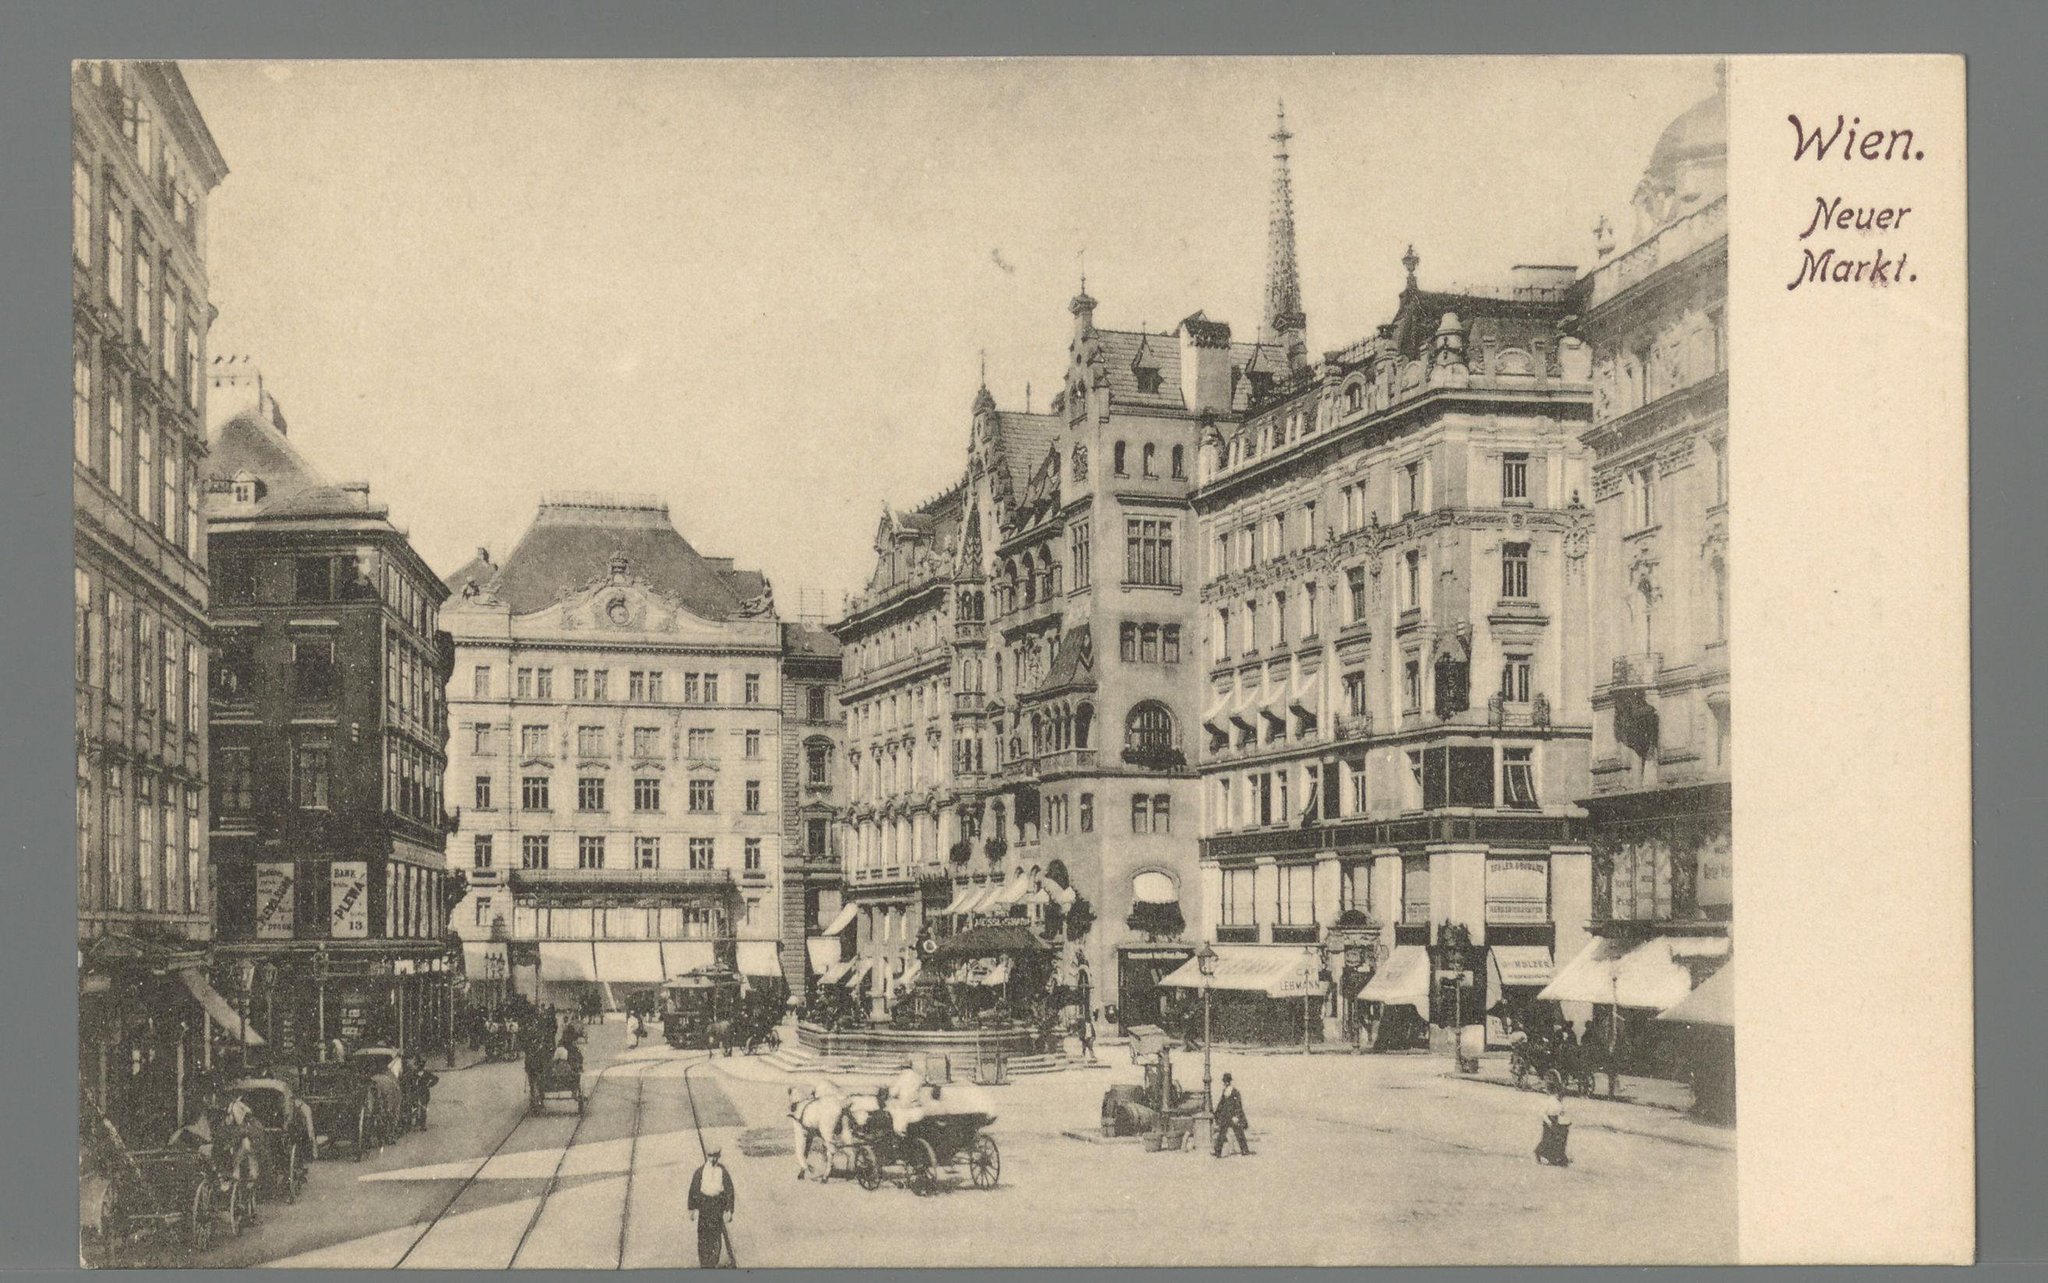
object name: ansichtkaart, prentbriefkaart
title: Wien. Neuer Markt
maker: Anonymous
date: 1915-1916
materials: cardboard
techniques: photograph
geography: vienna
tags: square, place, circus, etc.